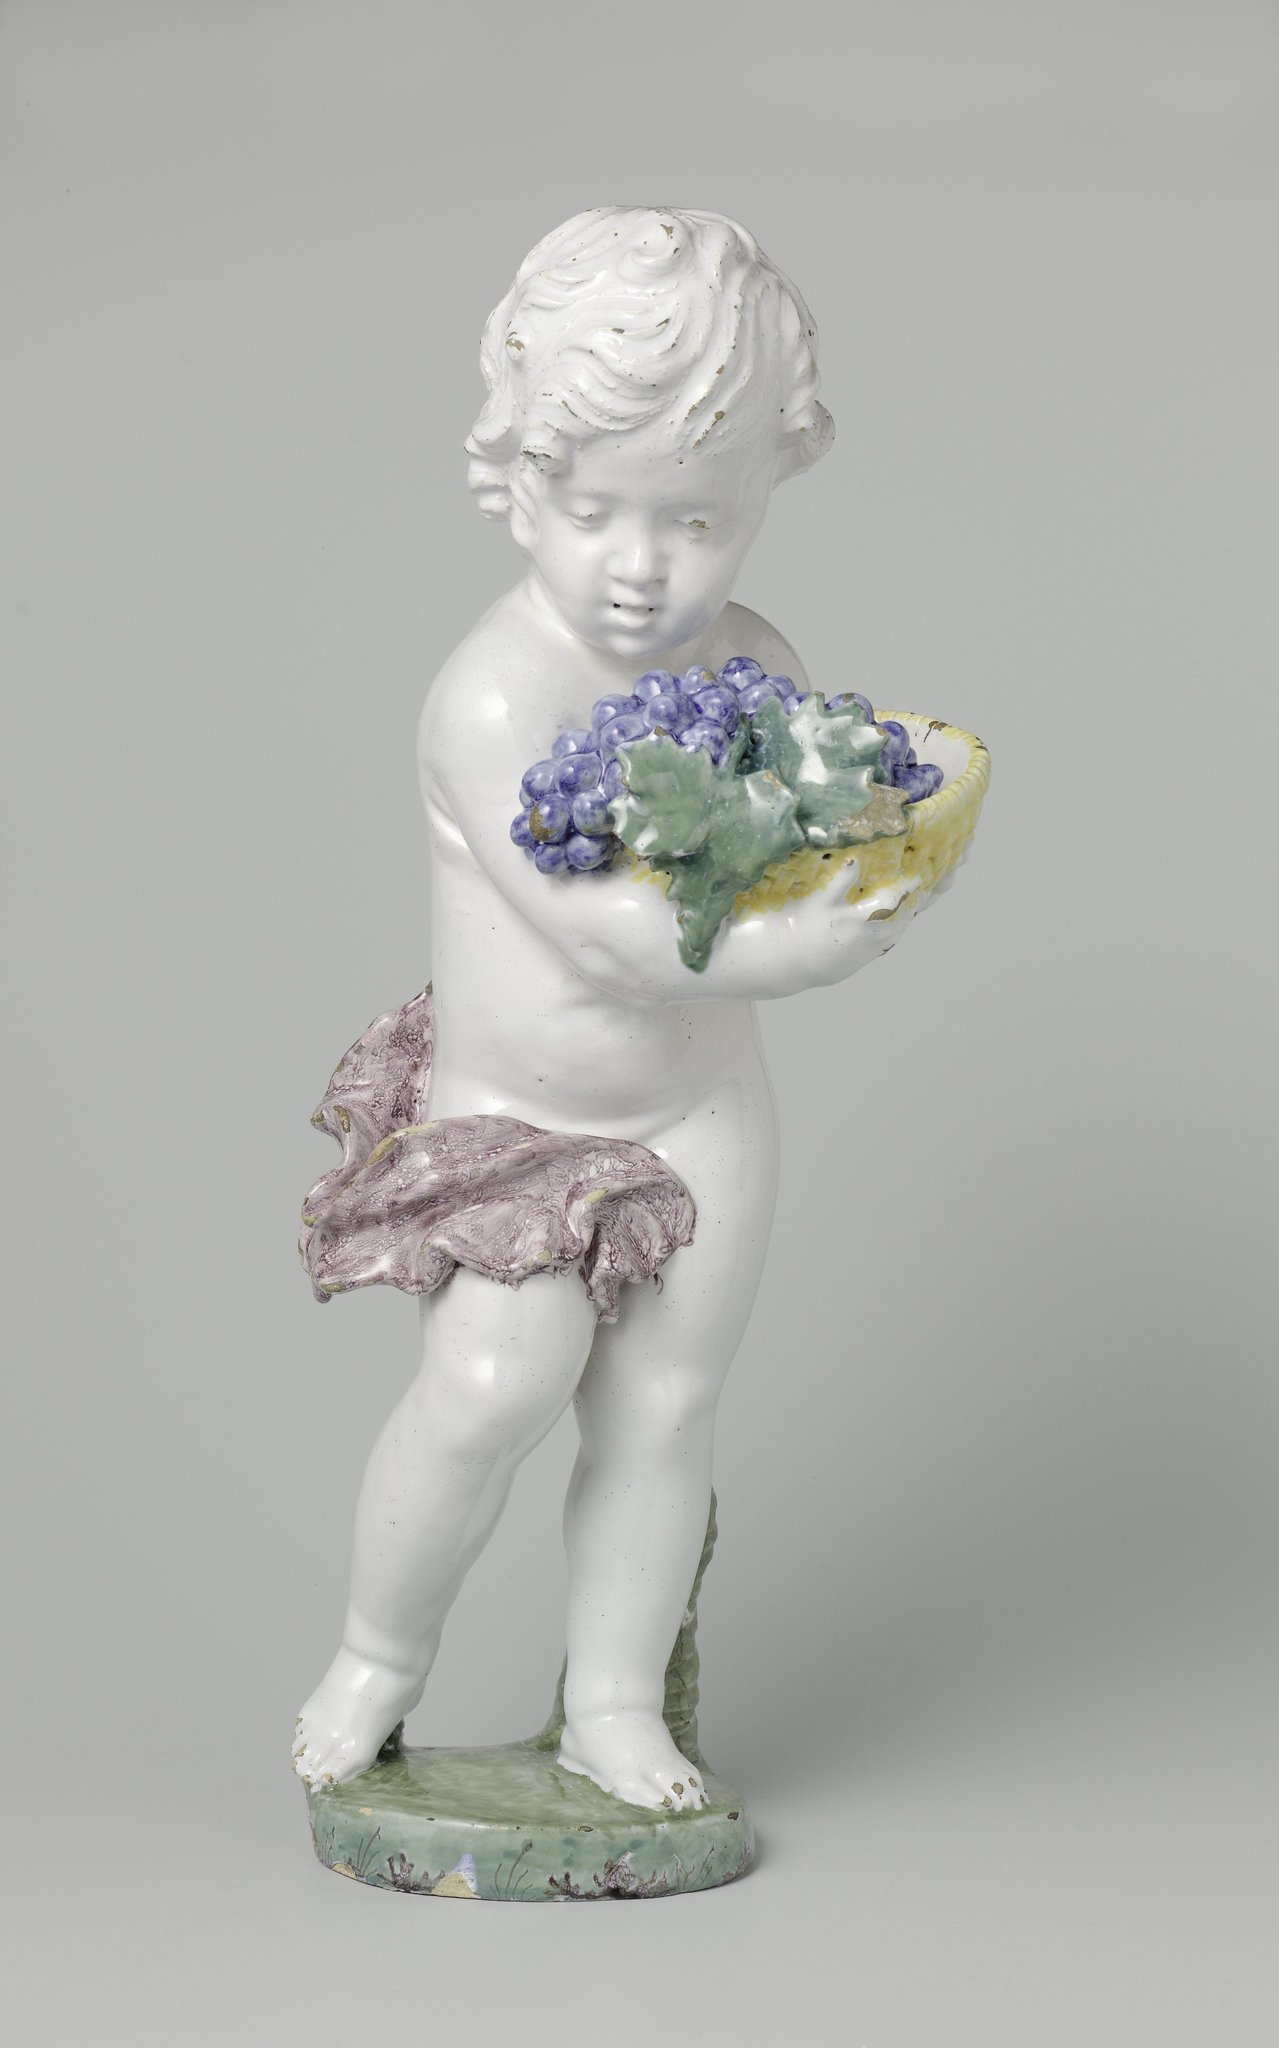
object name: putto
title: Putto van ongedecoreerde faïence met in rechterarm een mand met druiven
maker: Anonymous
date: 1750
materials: earthenware, glaze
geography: brussels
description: Beeld van ongedecoreerde faïence, voorstellende een putto met in zijn rechterarm een mand met druiven. Bij het beeld hoort een tweede beeld.